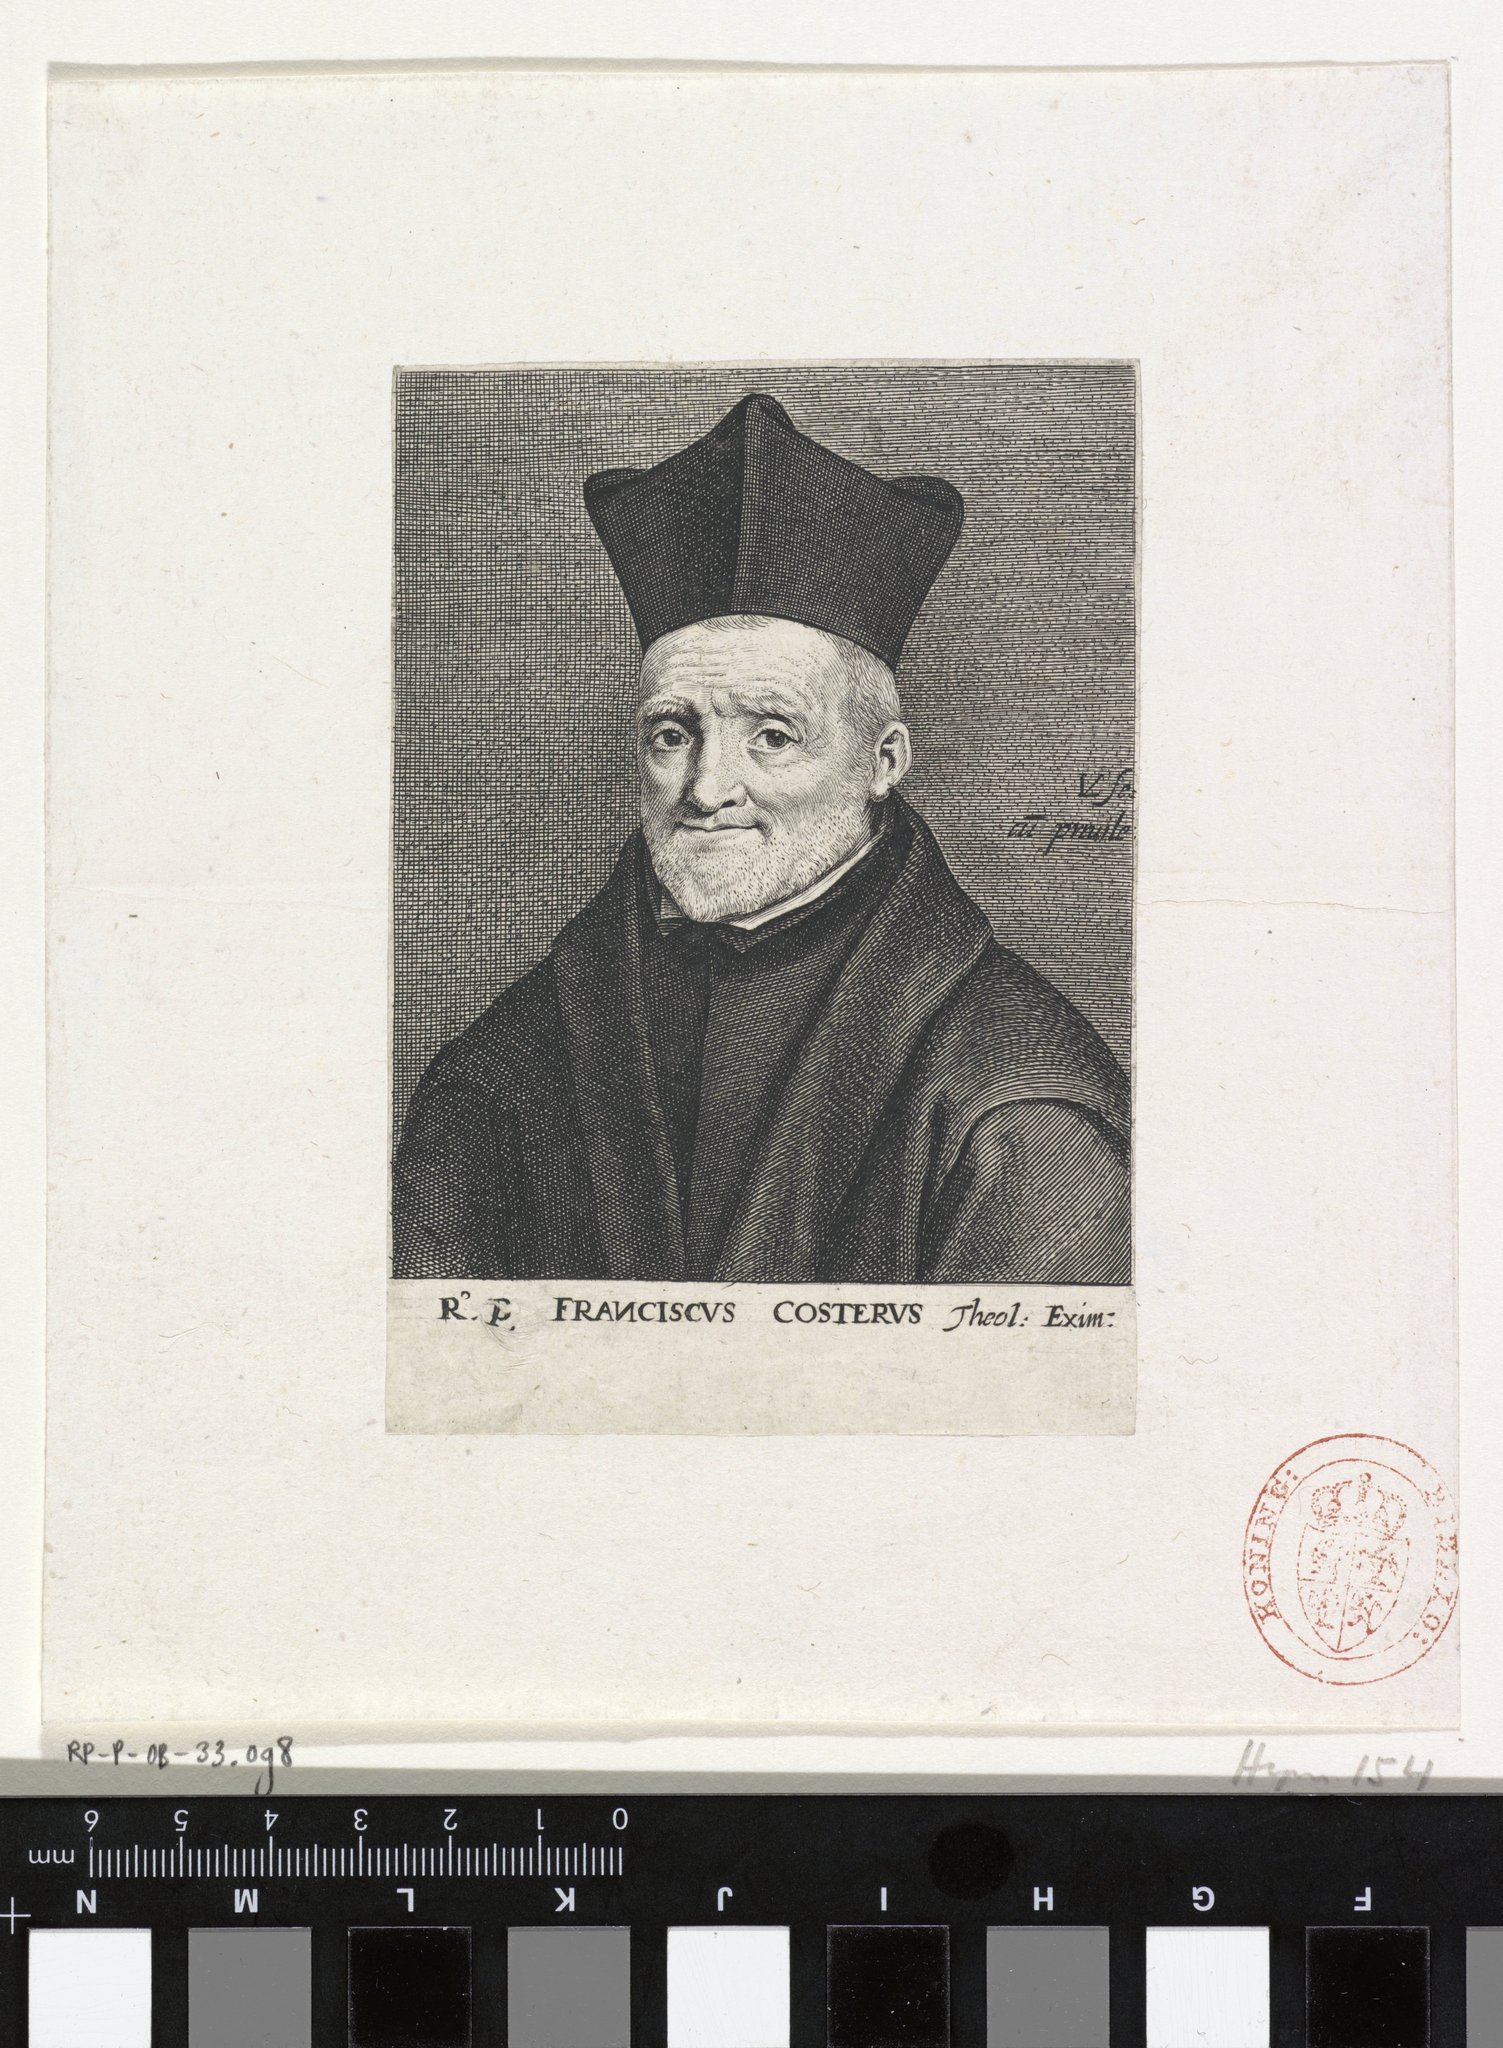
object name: print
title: Portret van Franciscus Costerus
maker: lucas vorsterman (i)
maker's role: print maker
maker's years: 1595-1675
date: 1619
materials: paper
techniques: engraving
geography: antwerp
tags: mechelen, brussels, clergyman, insignia of cardinal, e.g. hat, mantle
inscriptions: inscription: Lugt 240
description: Portret van de katholiek geestelijke en schrijver Franciscus Costerus.